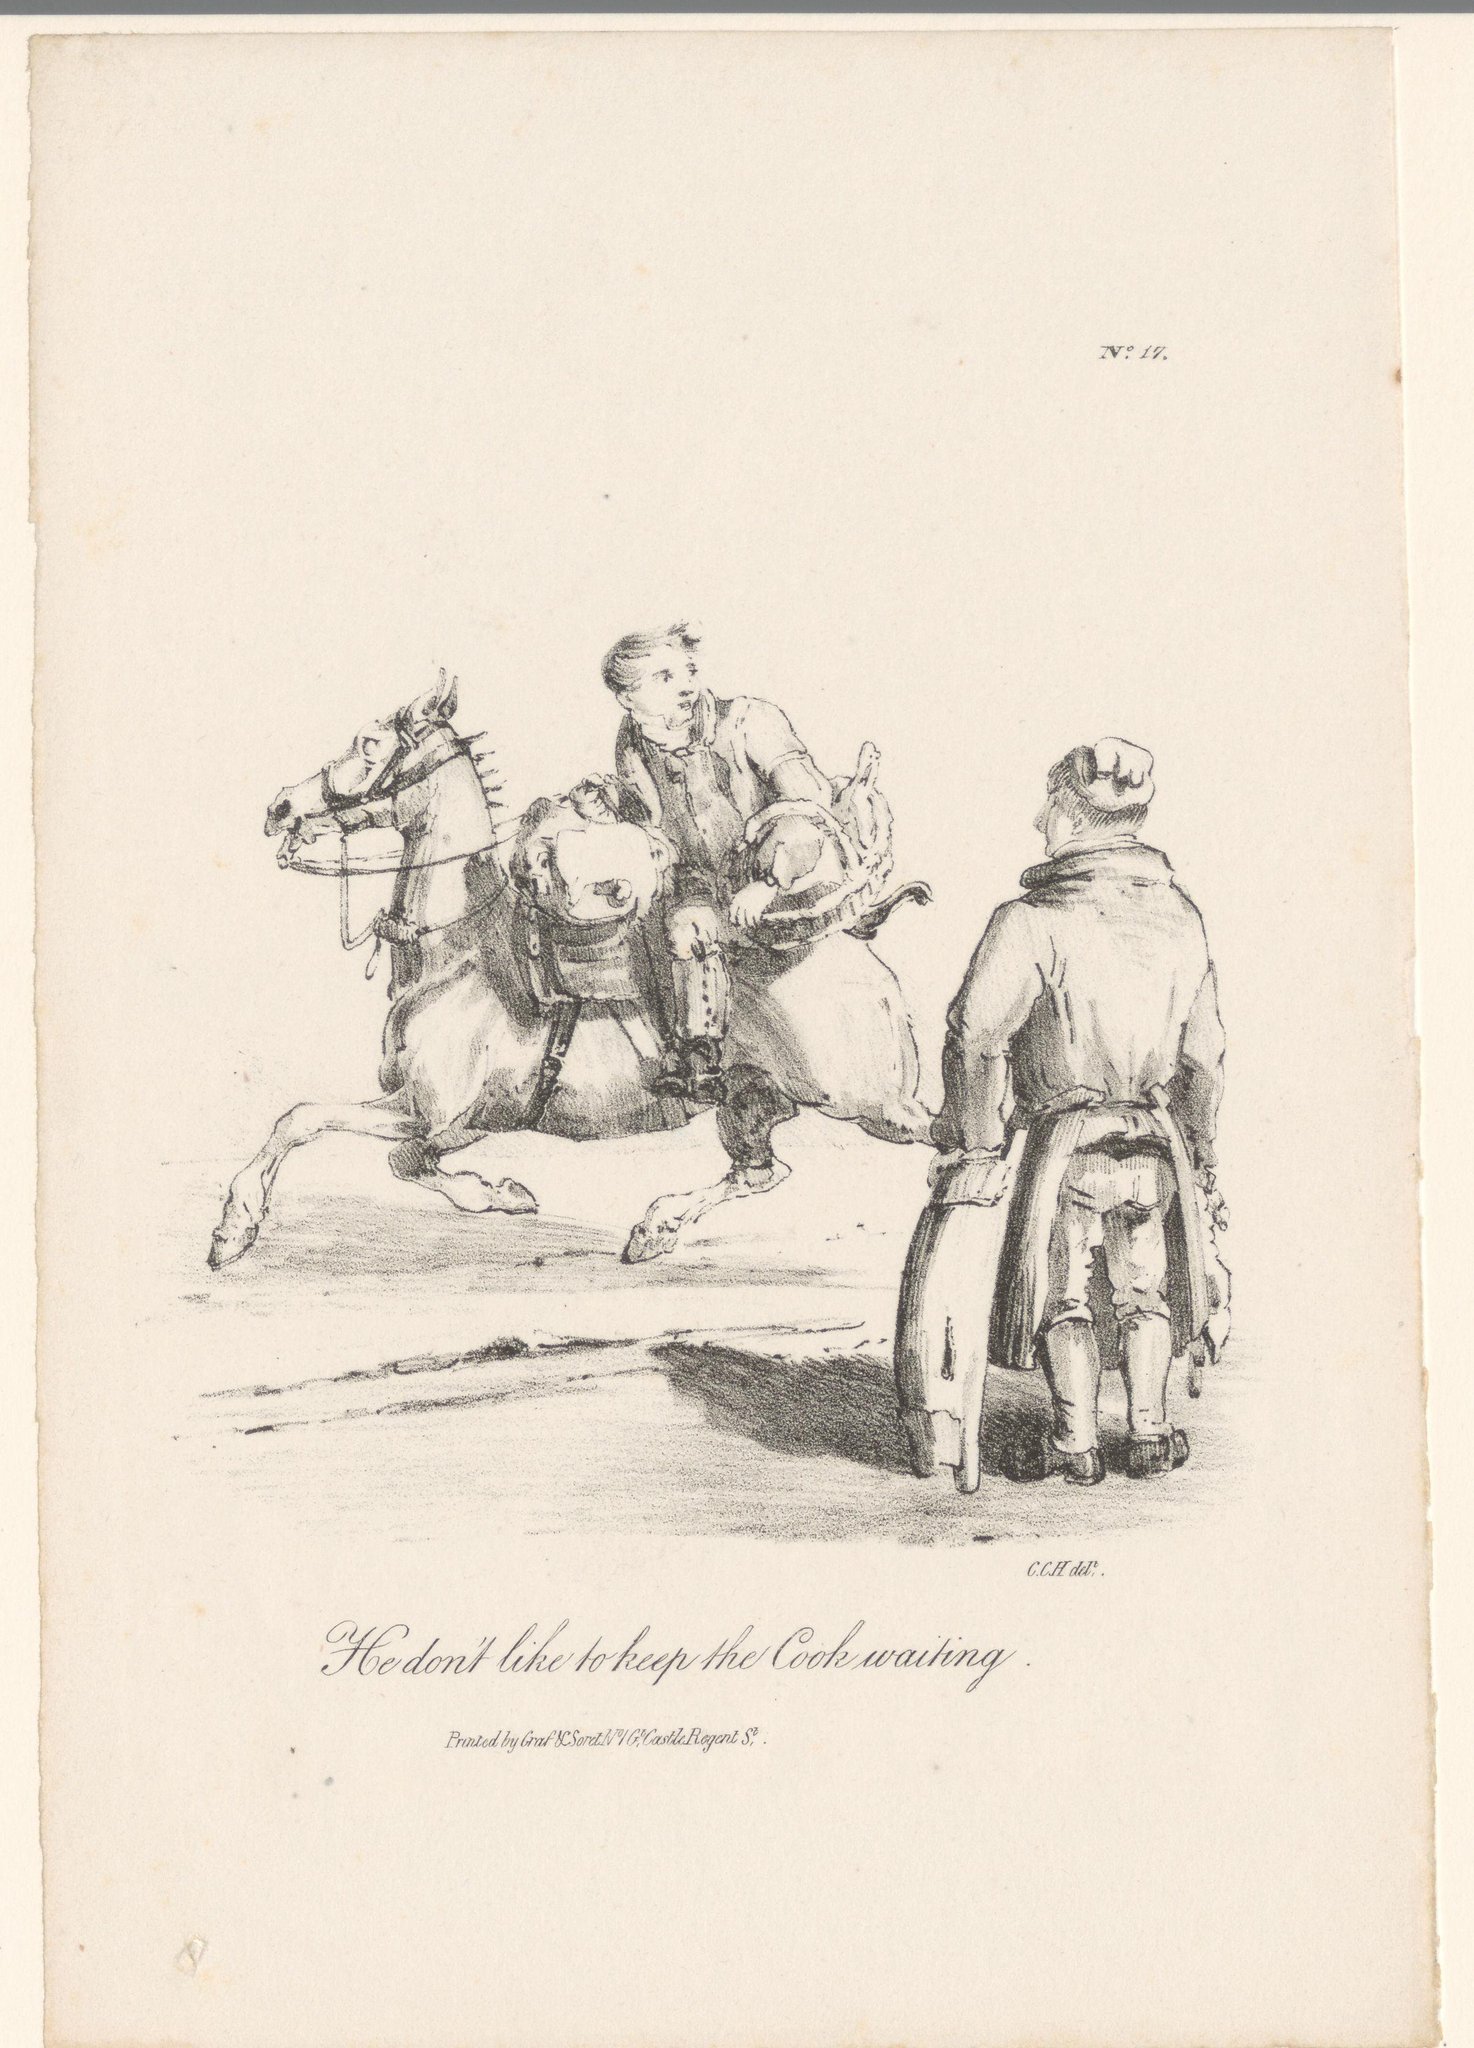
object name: cartoon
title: Diverse spotprenten over de Engelse bevolking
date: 1830-1838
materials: paper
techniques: lithograph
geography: london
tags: riding a horse, ass, or mule; rider, horseman, adult man, galloping horse, political caricatures and satires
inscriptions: collector's mark: Lugt 2228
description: Prent maakt deel uit van een serie met spotprenten. Over deze serie is verder niets bekend. Het betreft voornamelijk voorstellingen over de Engelse bevolking.